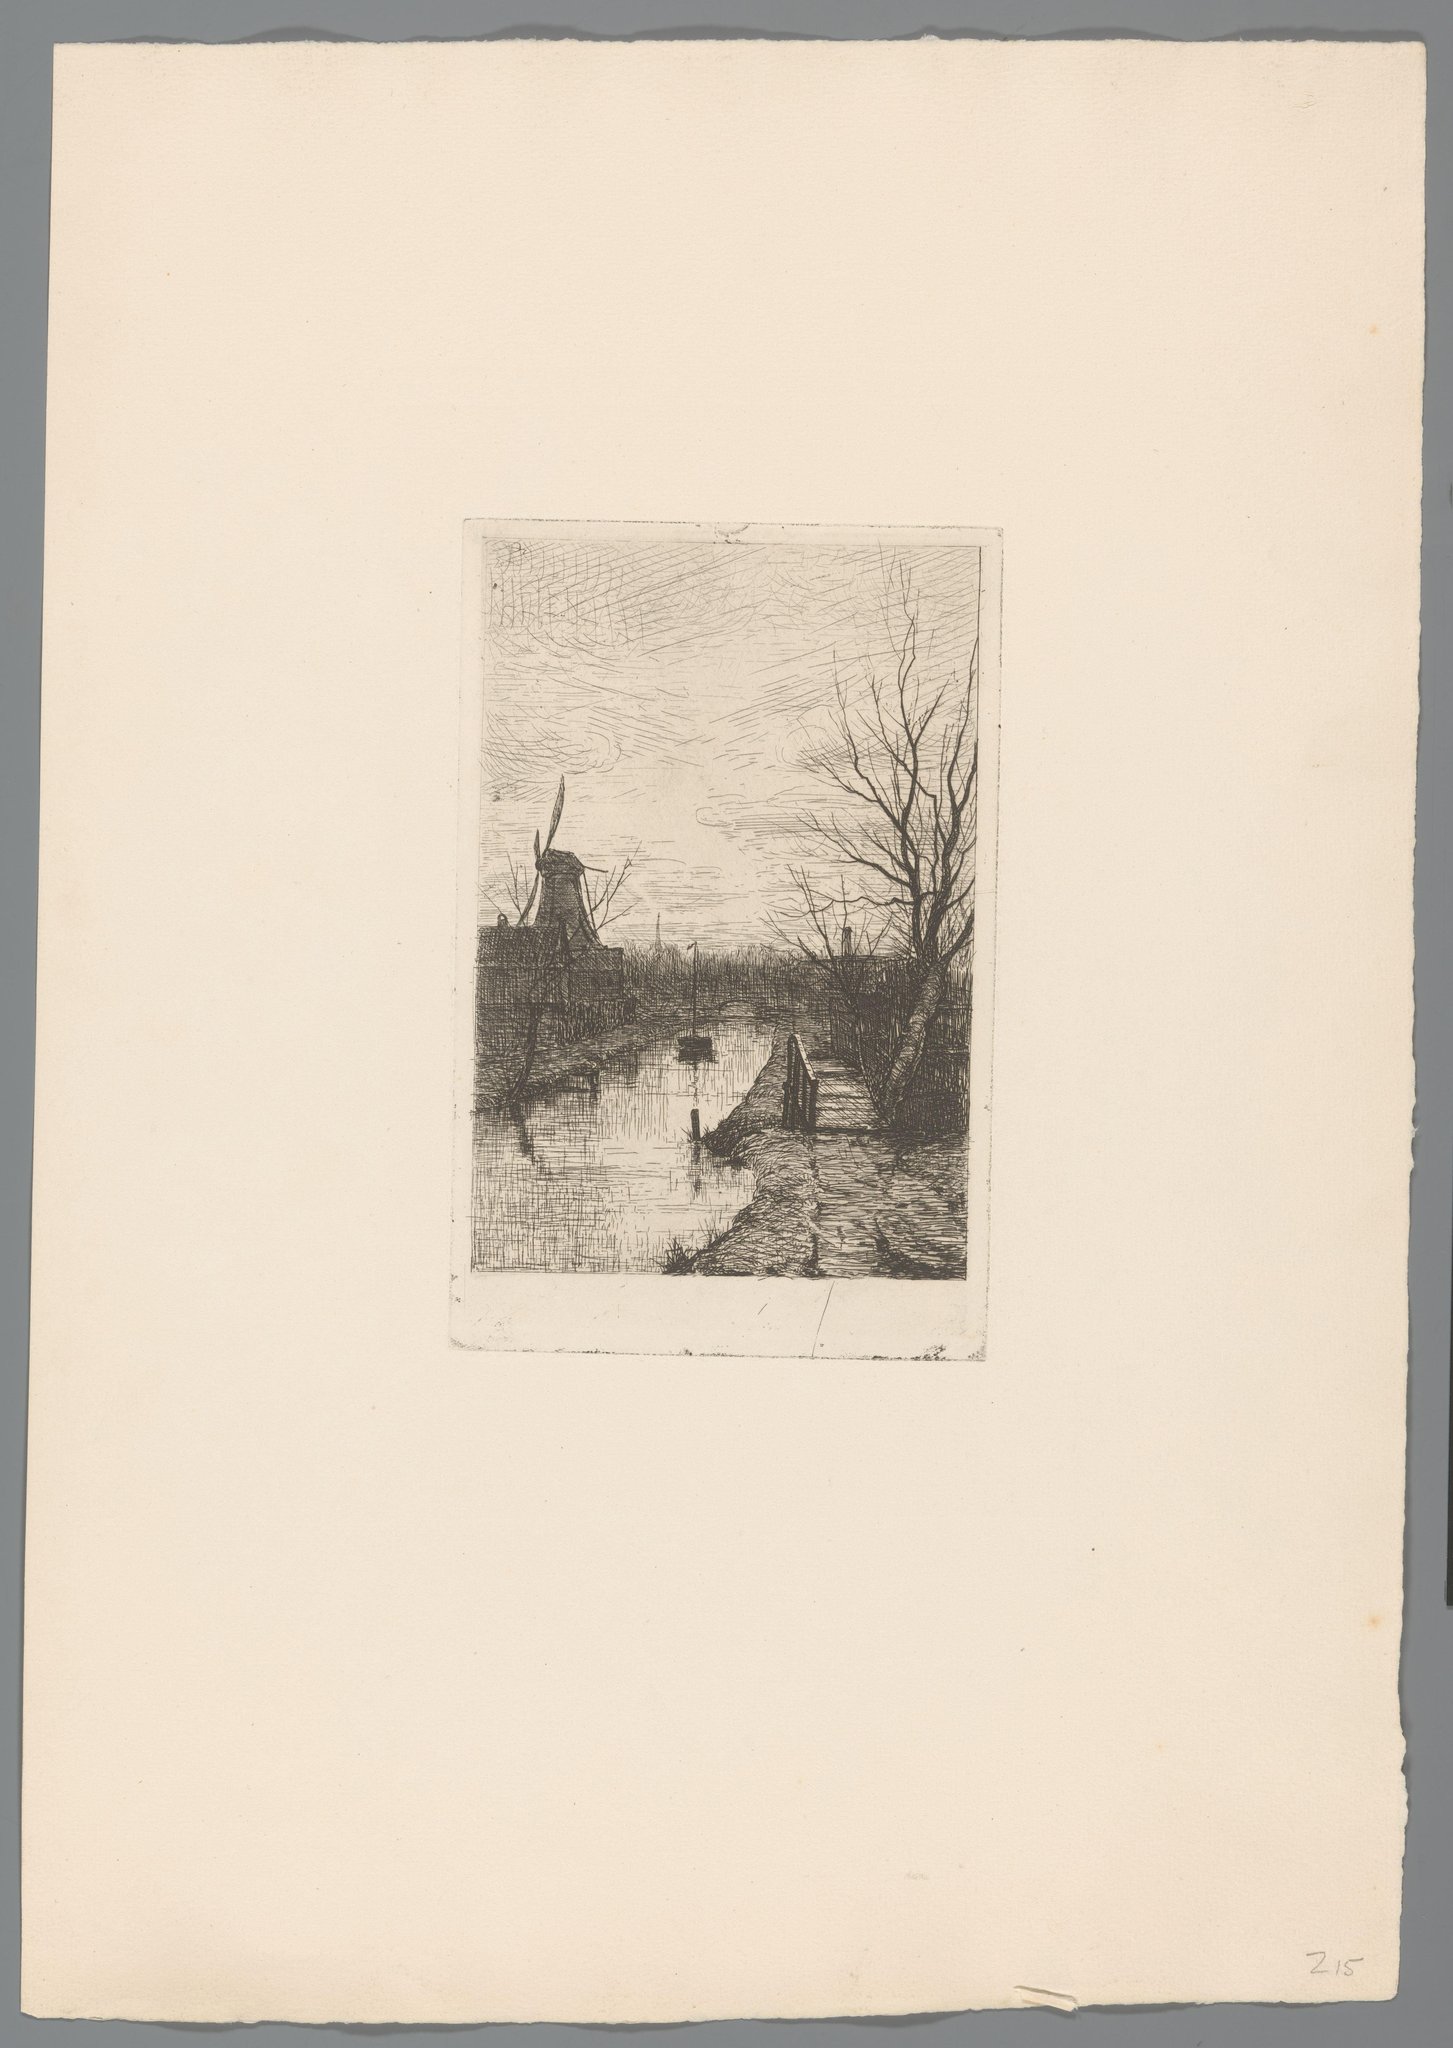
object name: print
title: Landschap met vaart, molen en loopbrug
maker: philip zilcken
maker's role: draughtsman, painter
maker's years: 1857-1930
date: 1883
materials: paper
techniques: etching, intaglio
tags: canal, windmill in landscape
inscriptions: collector's mark: Lugt 2228